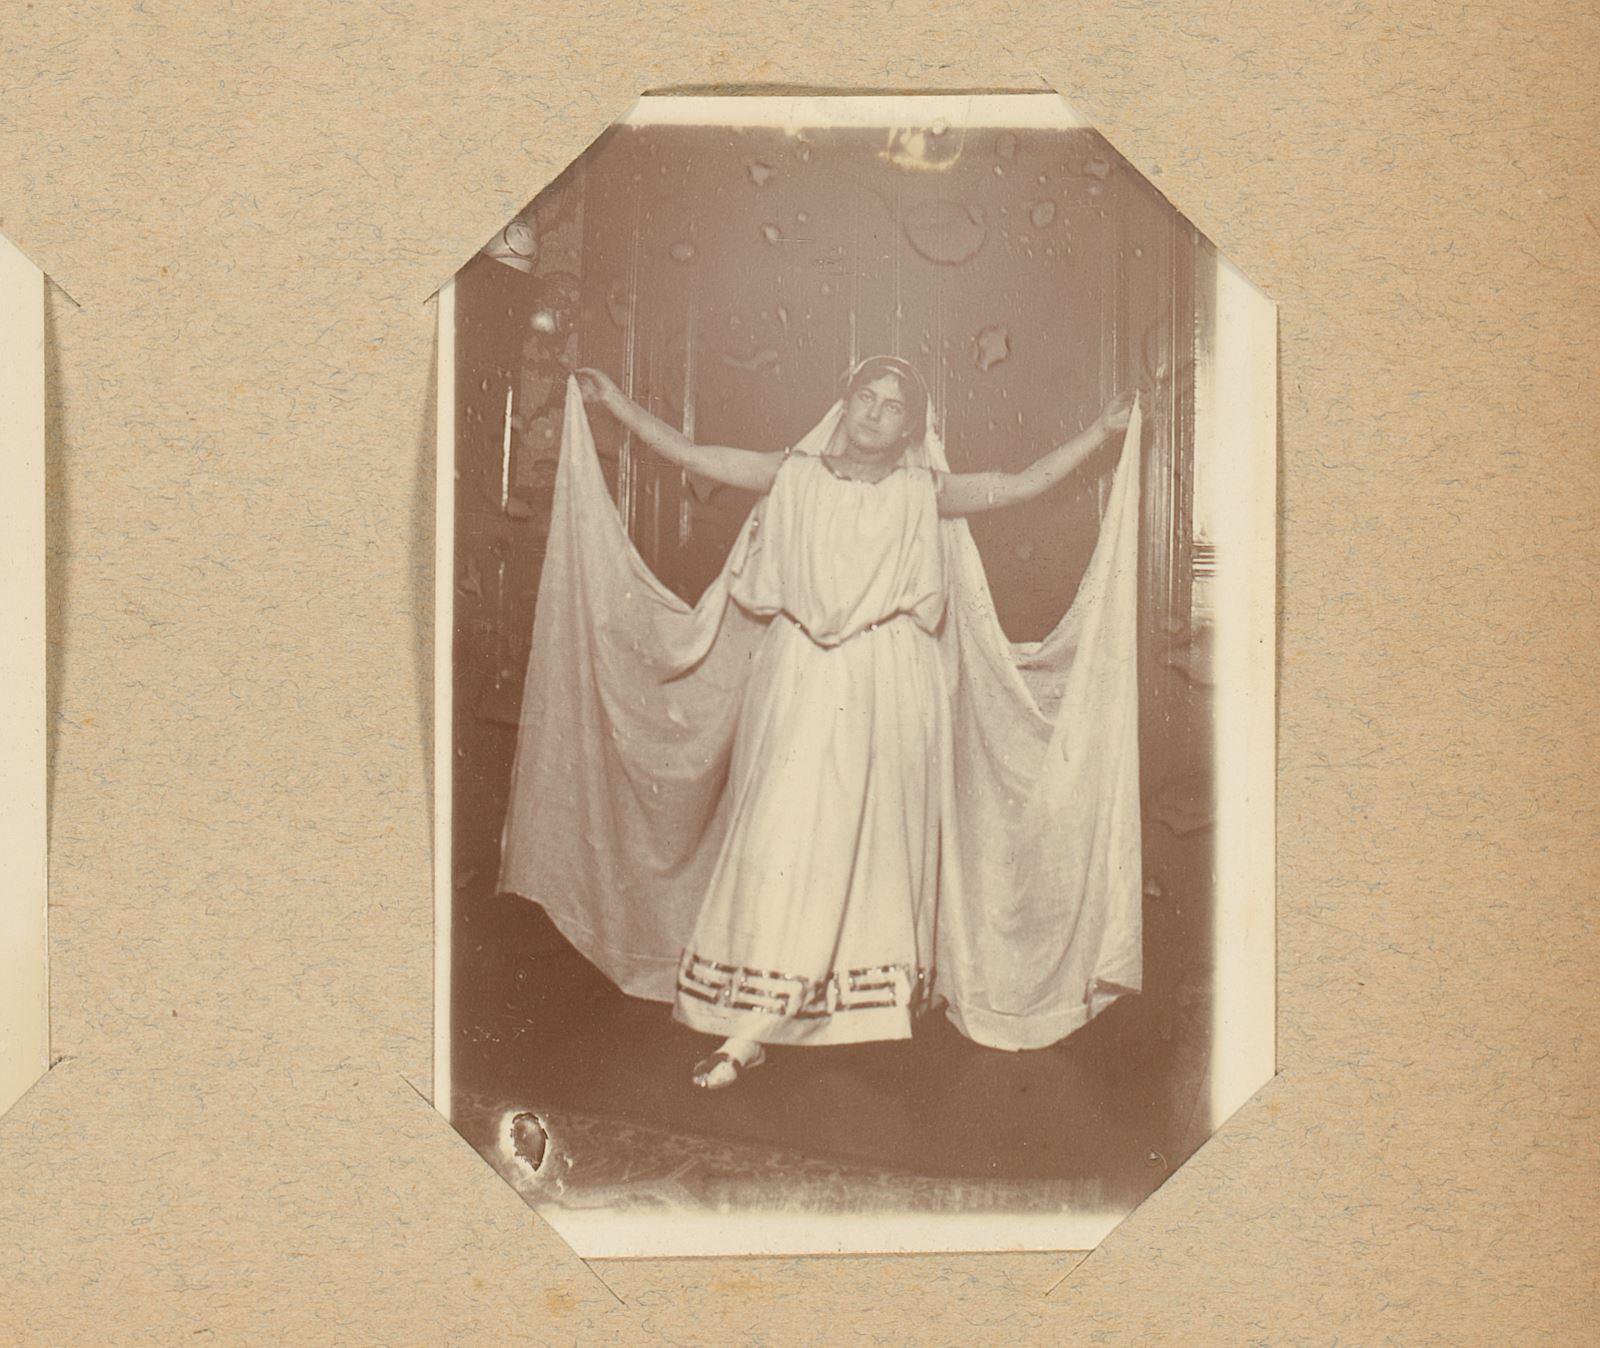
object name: album leaf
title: Portret van een vrouw in verkleedkleding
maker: Anonymous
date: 1897-1900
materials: paper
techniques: gelatin silver print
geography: france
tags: adult woman, historical persons, historical costume, france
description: Over de foto is een ander negatief afgedrukt van een voorstelling van bomen.